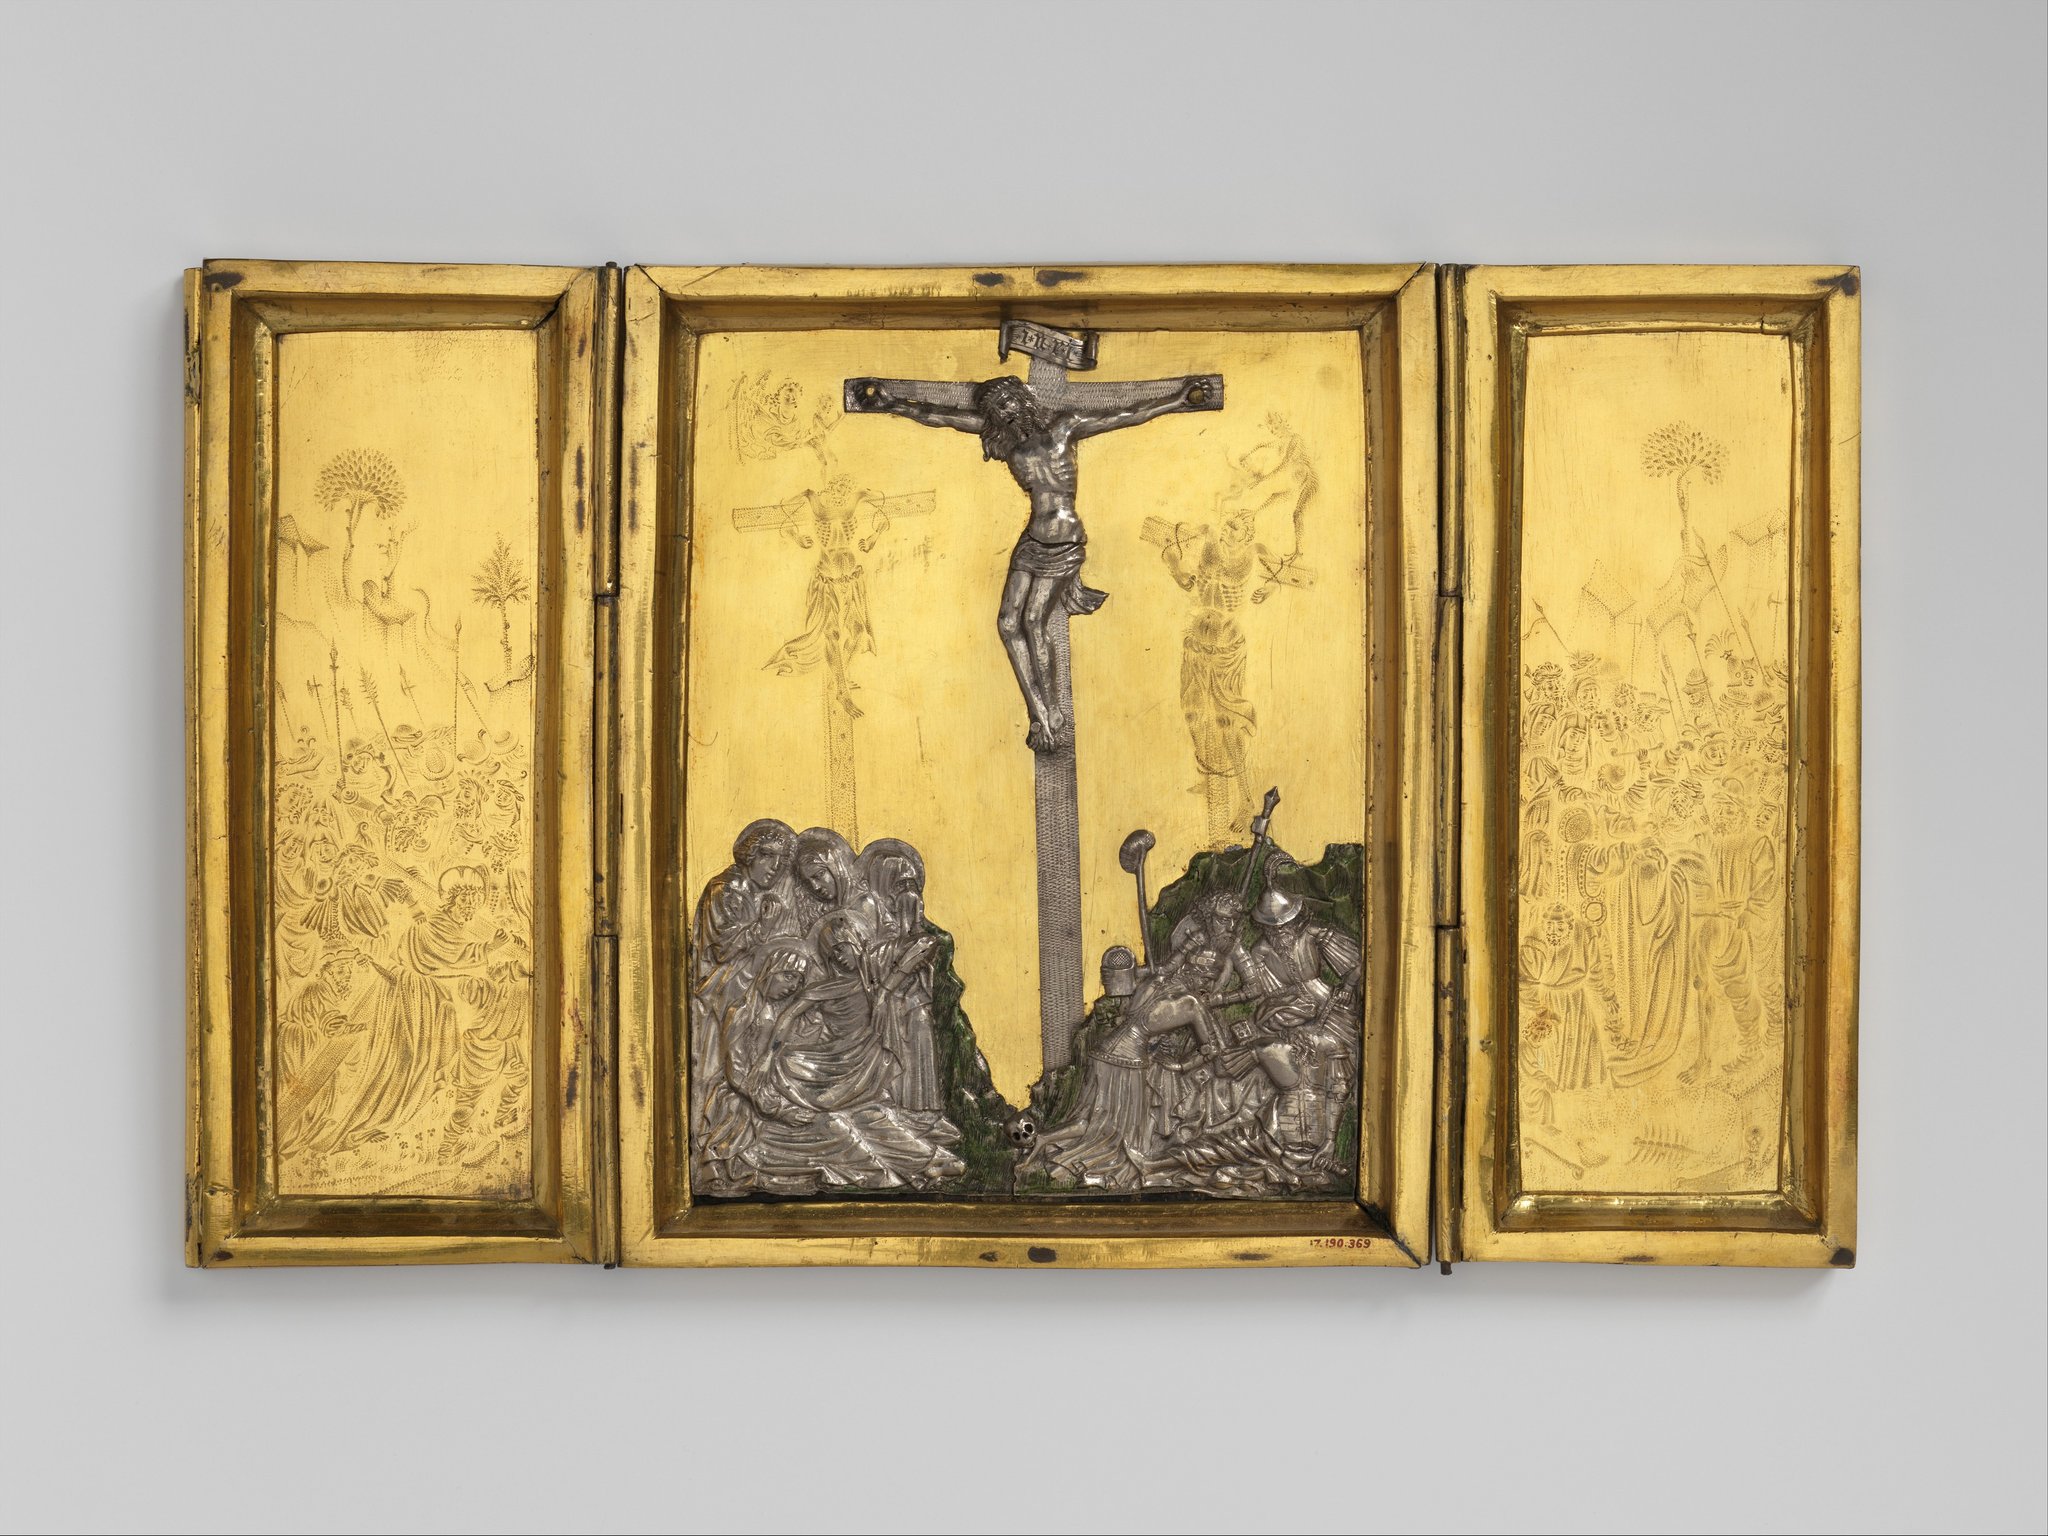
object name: triptych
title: Triptych with the Way to Calvary, the Crucifixion, and the Disrobing of Jesus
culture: dutch or french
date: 1400-1420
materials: gilt copper, paint, silver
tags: soldiers,angels,christ,virgin mary,annunciation,crucifixion